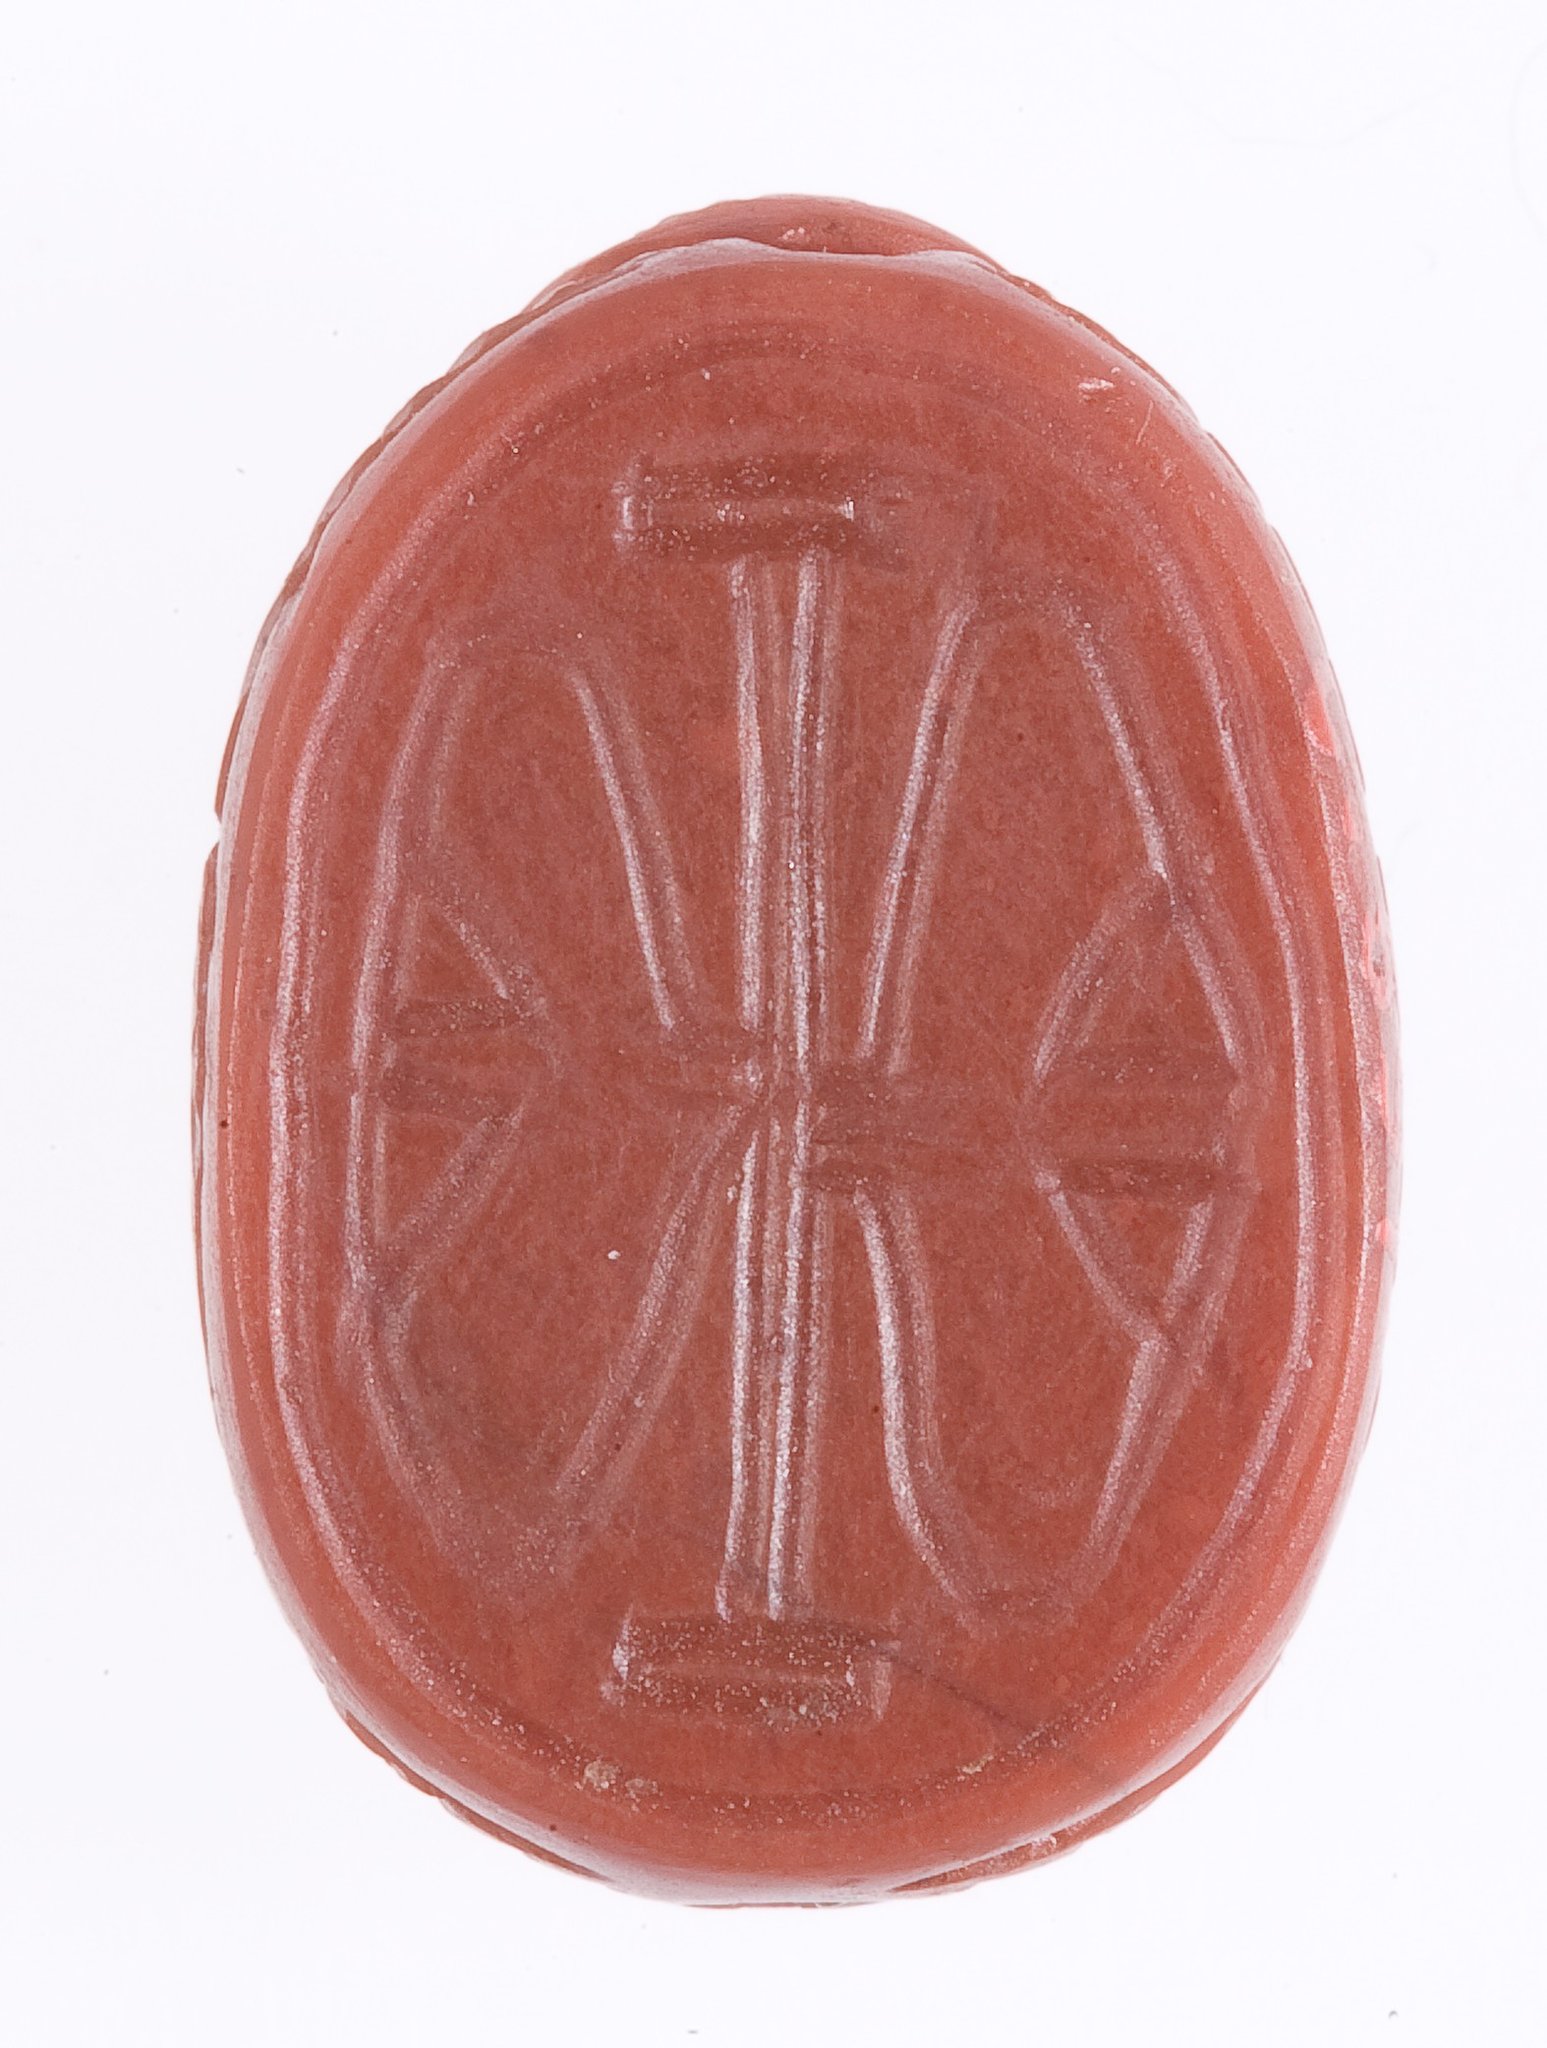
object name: scarab, private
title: Scarab Inscribed With a Private Name (?)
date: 1550-1458 BCE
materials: jasper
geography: egypt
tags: scarabs